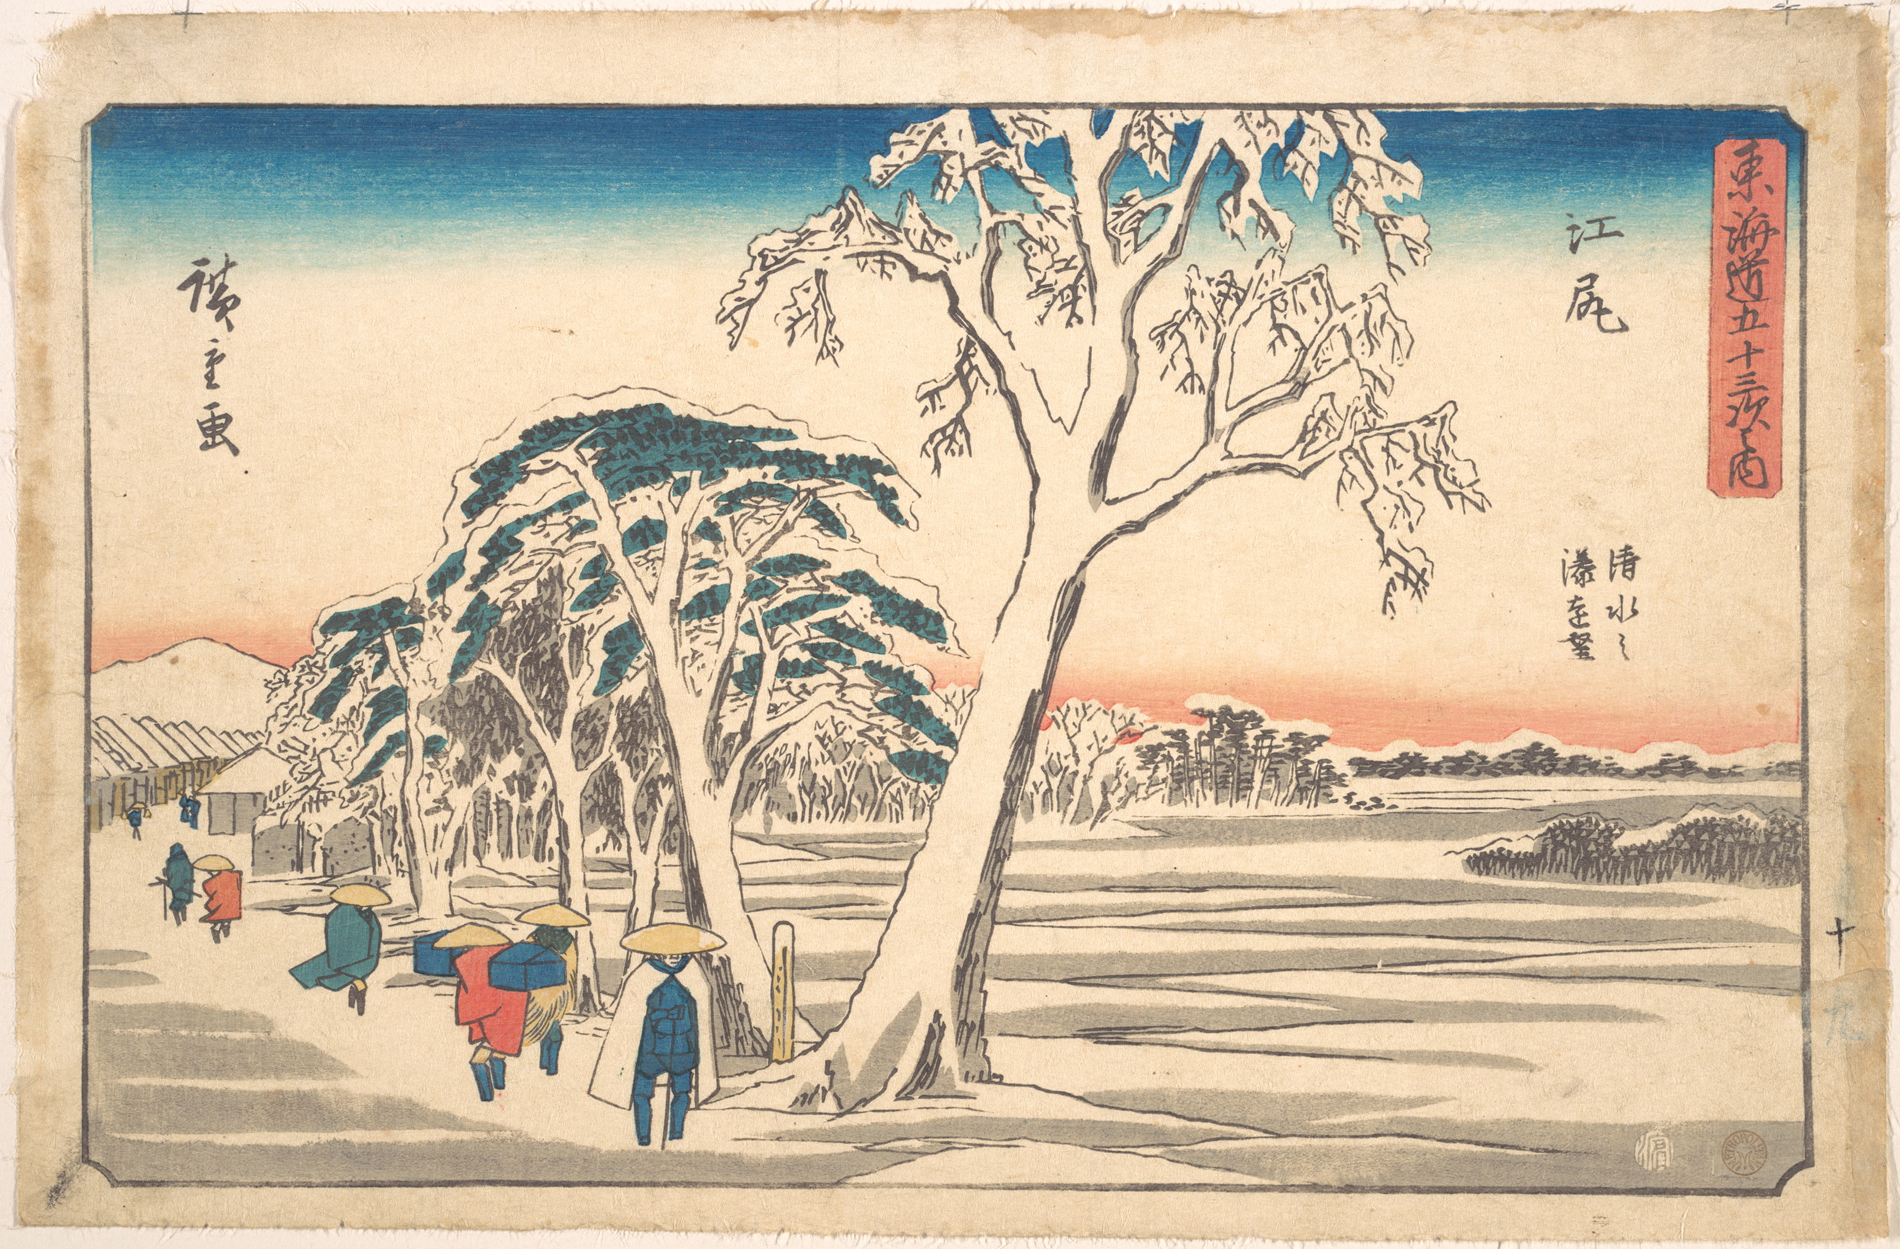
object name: print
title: Ejiri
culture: japanese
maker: utagawa hiroshige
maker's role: artist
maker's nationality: japanese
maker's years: 1797-1858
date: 1842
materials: ink, paper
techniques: woodblock print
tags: human figures,landscapes,trees,snow